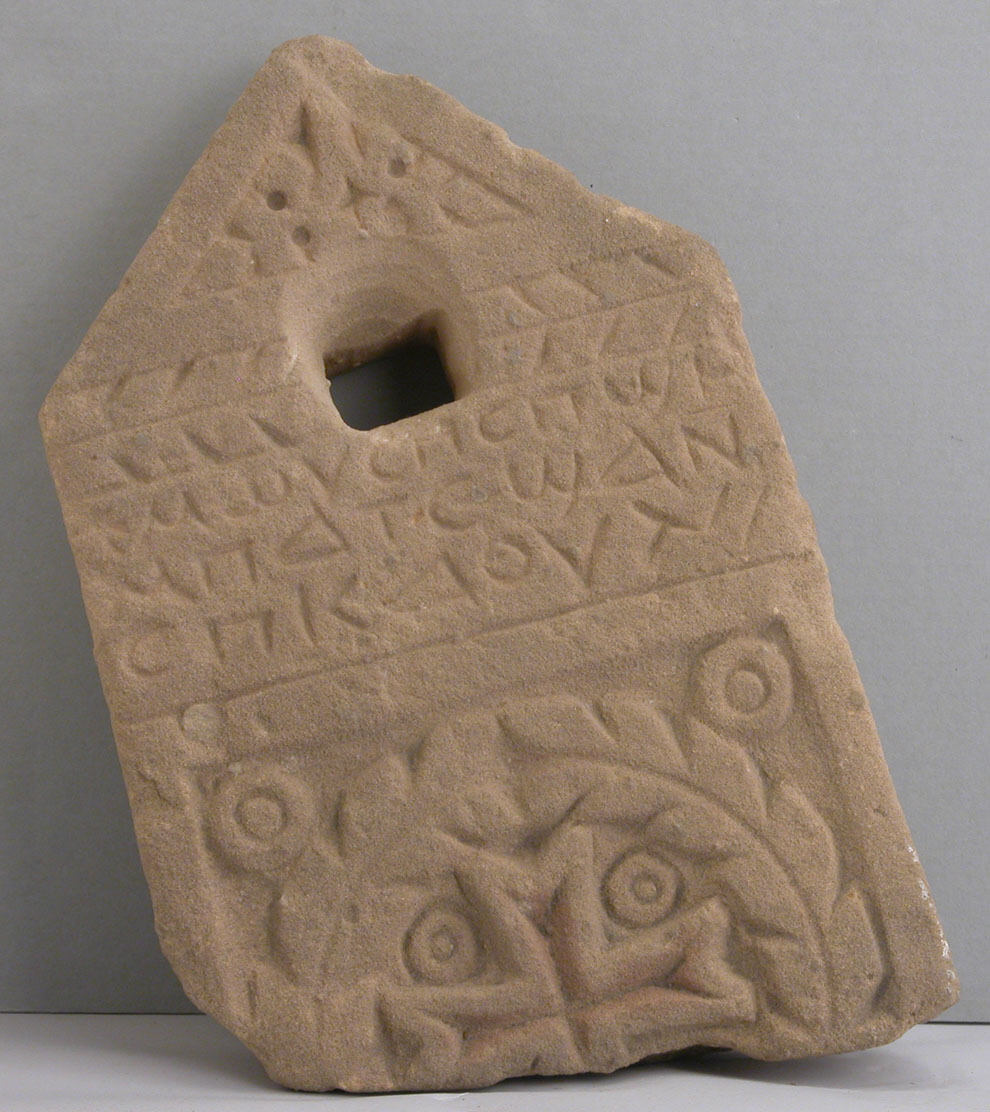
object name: fragment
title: Fragment of an Inscribed Stele with a Cross within a Wreath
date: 601-800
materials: stone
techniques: carving, incising, relief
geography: egypt